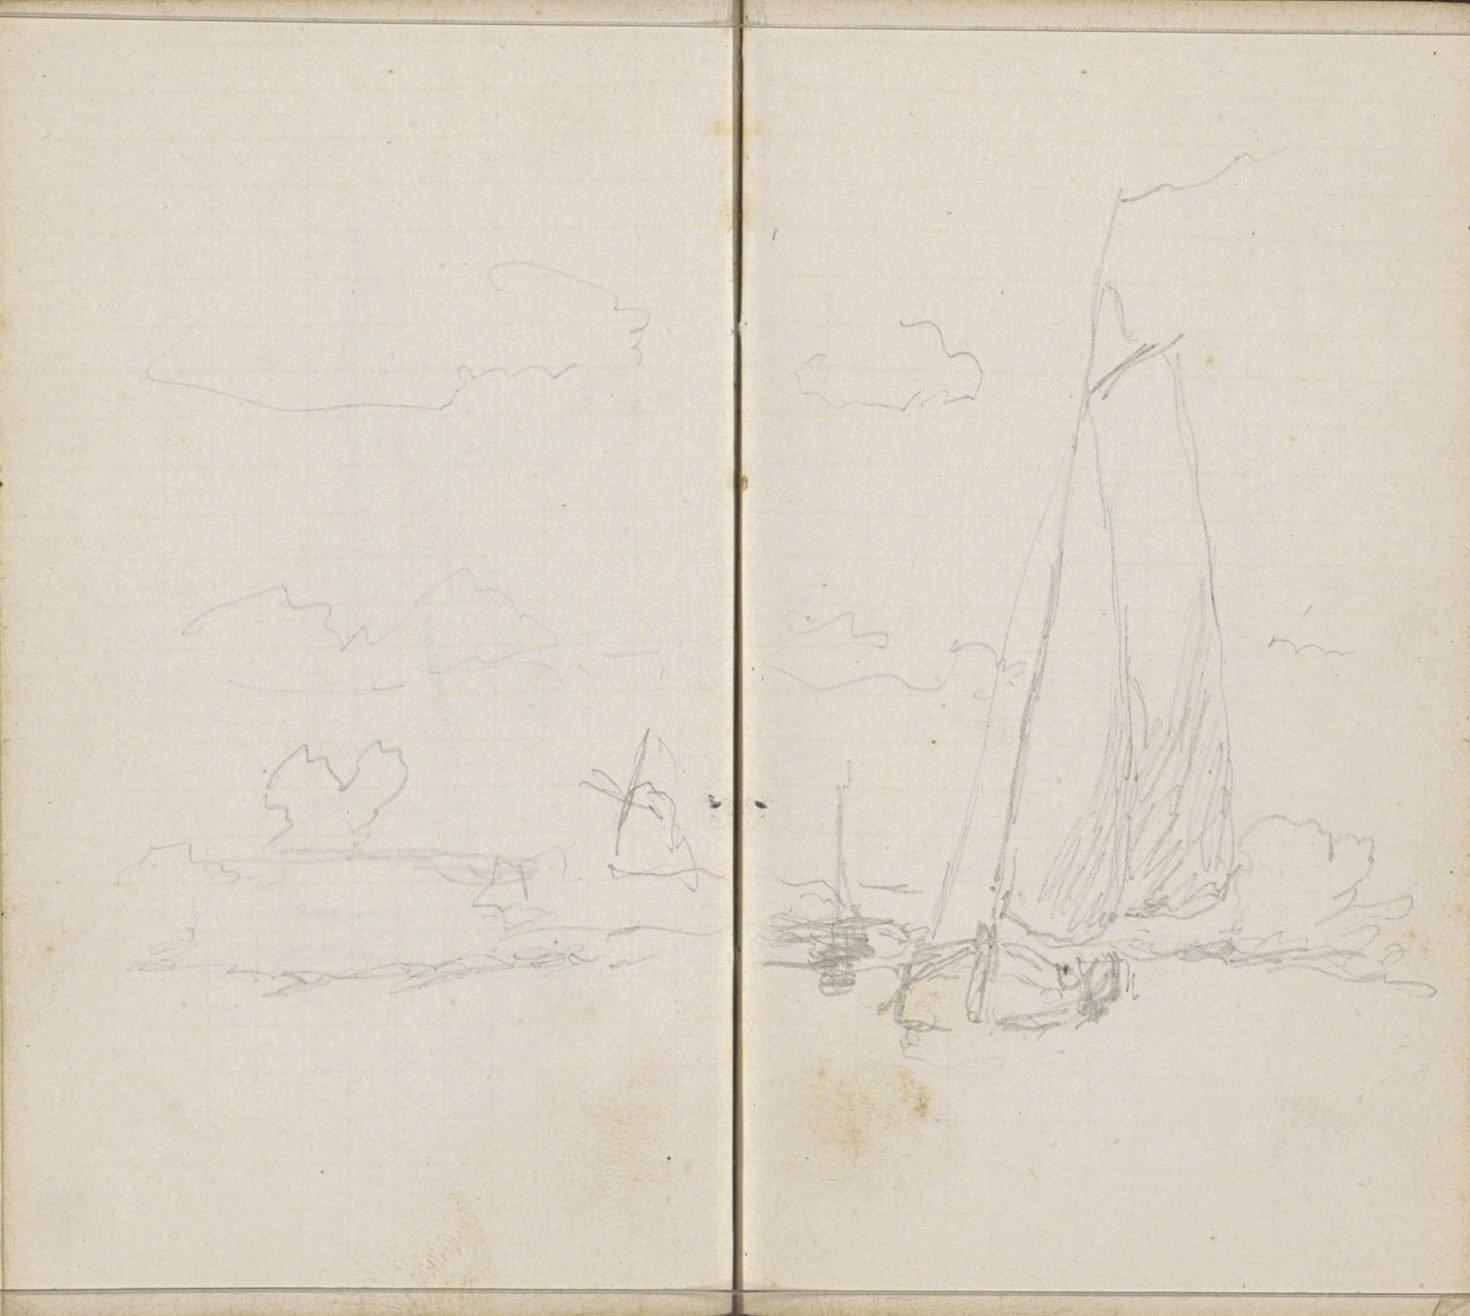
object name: sketchbook leaf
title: Zeilboten op het water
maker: jan willem van borselen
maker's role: draughtsman, print maker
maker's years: 1825-1892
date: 1868-1887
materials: pencil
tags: sailing-ship, sailing-boat, landscapes with waters, waterscapes, seascapes (in the temperate zone)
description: Blad 37 verso en 38 recto uit een schetsboek met 51 bladen.